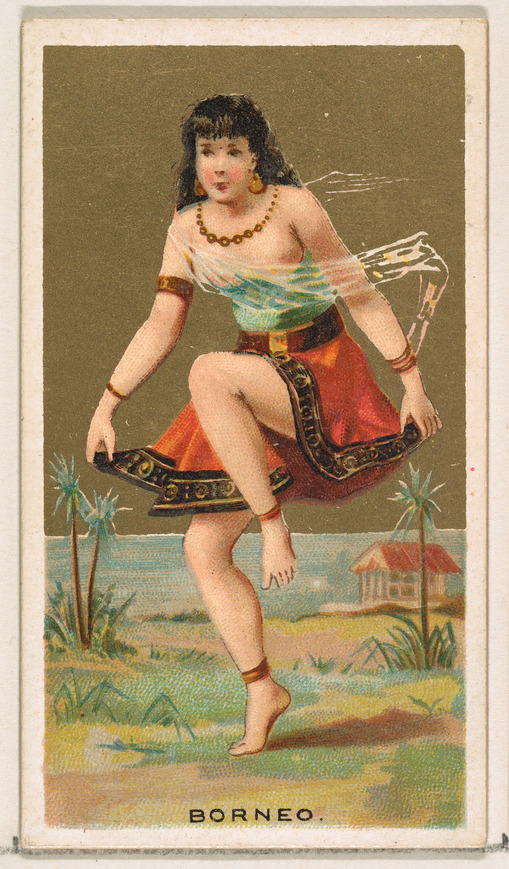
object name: print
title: Borneo, from the Dancing Girls of the World series (N185) issued by Wm. S. Kimball & Co.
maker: william s. kimball & company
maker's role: publisher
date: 1889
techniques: color lithograph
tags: girls,female nudes,dancing,dancers